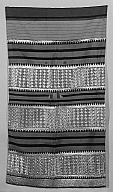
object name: skirt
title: Woman's Ceremonial Skirt (Tapis)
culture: lampung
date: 1801-1900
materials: cotton, gold, thread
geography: indonesia